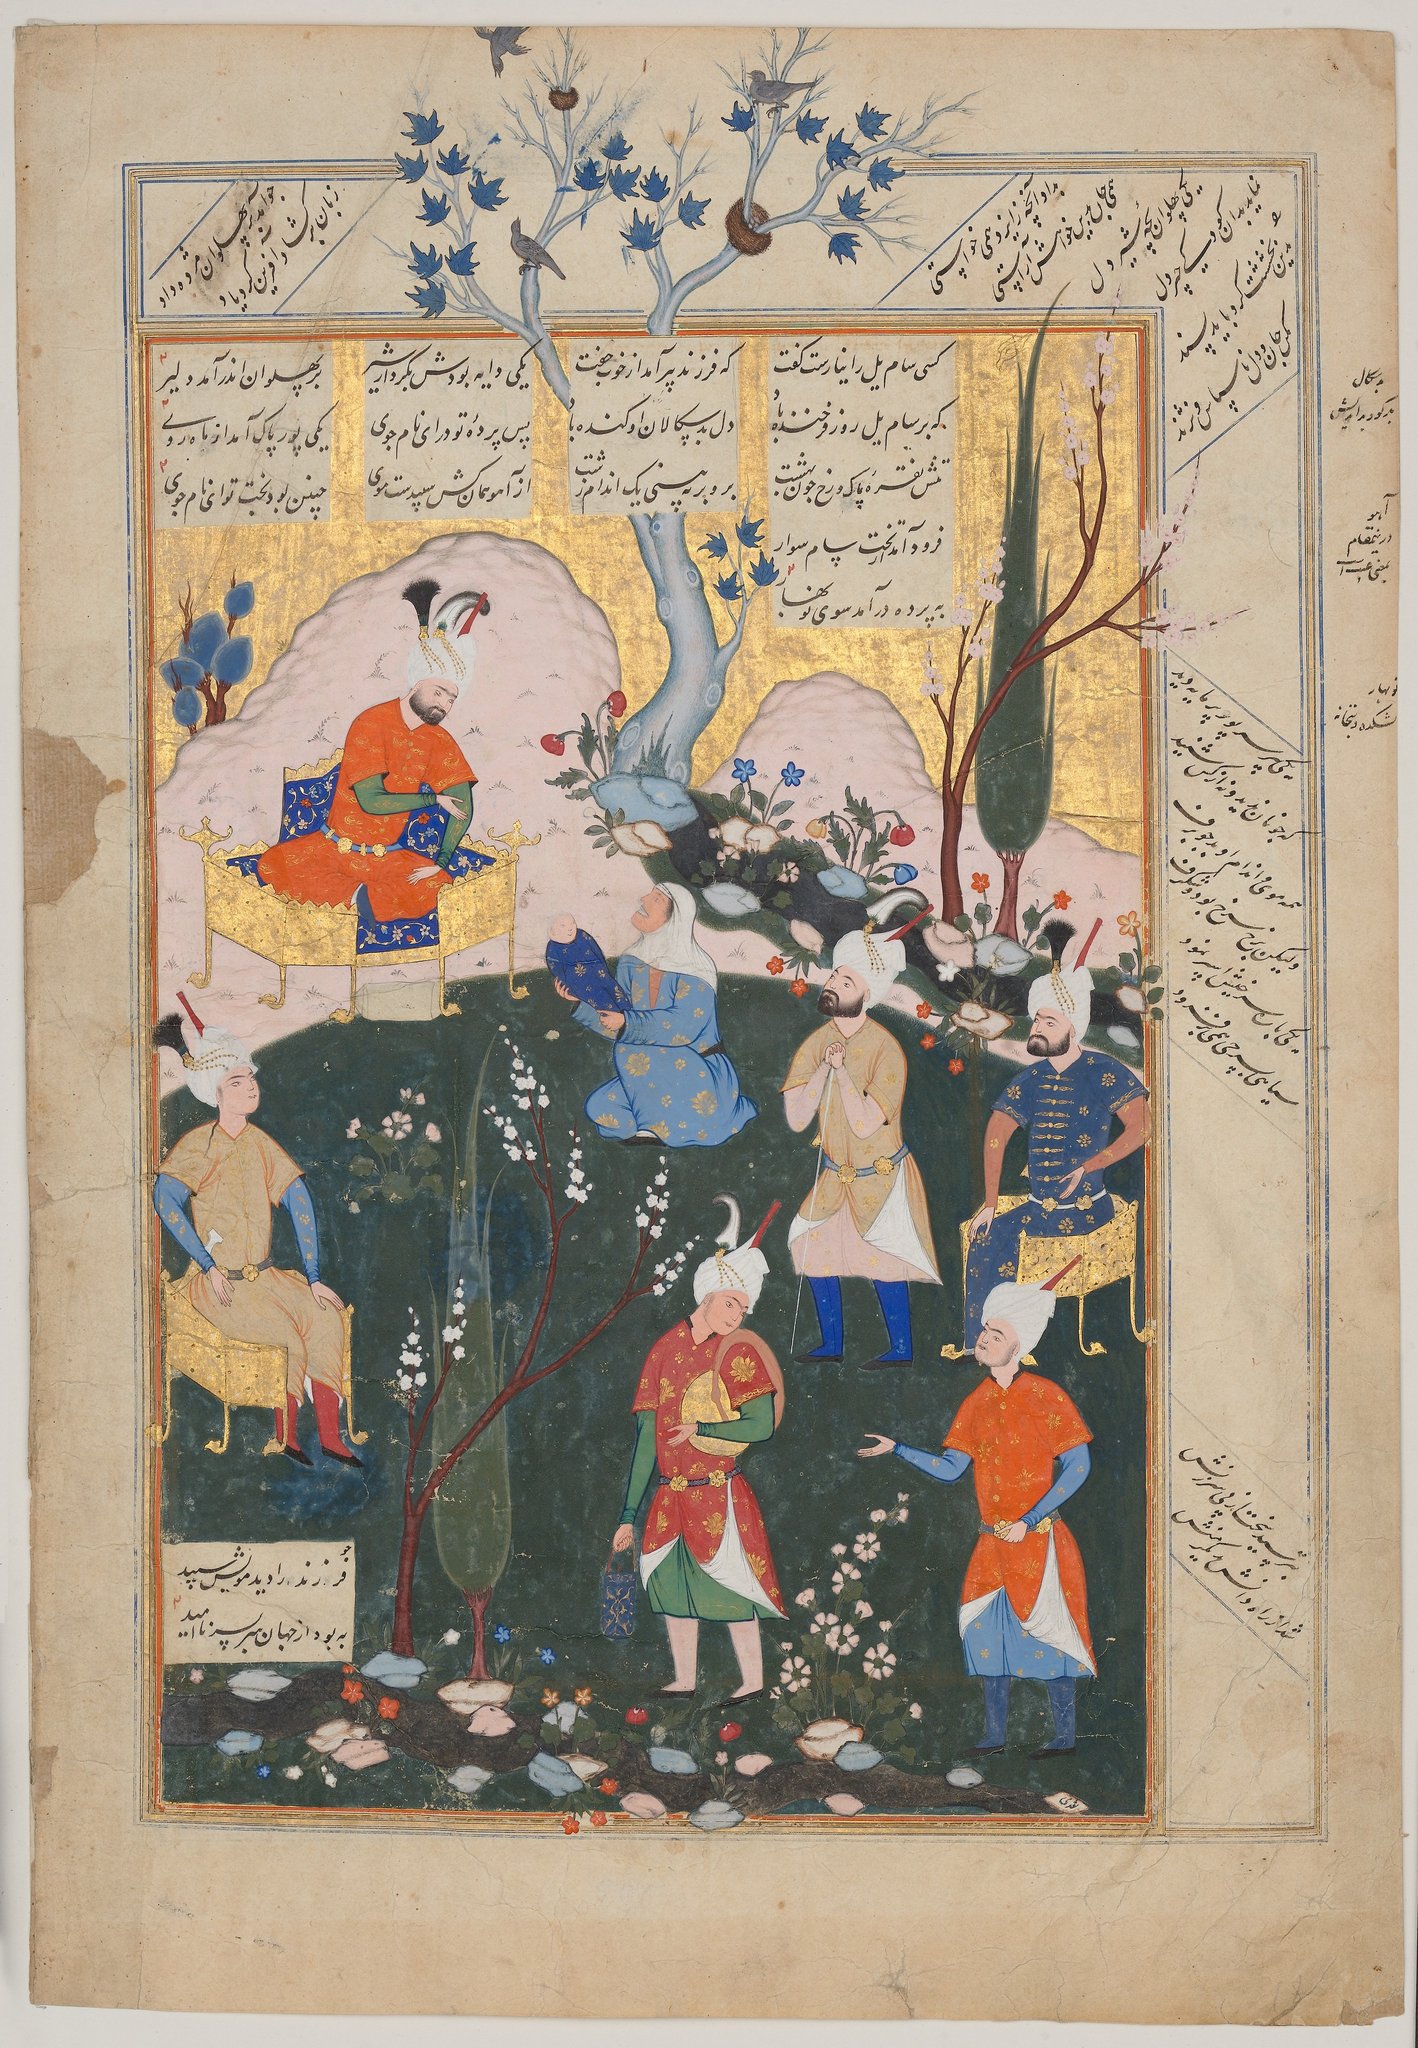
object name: folio from an illustrated manuscript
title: "Birth of Zal", Folio from a Shahnama (Book of Kings)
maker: abu'l qasim firdausi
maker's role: author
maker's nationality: iranian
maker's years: 935-1020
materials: gold, ink, paper, watercolor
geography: iran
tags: birds,kings,infants,men